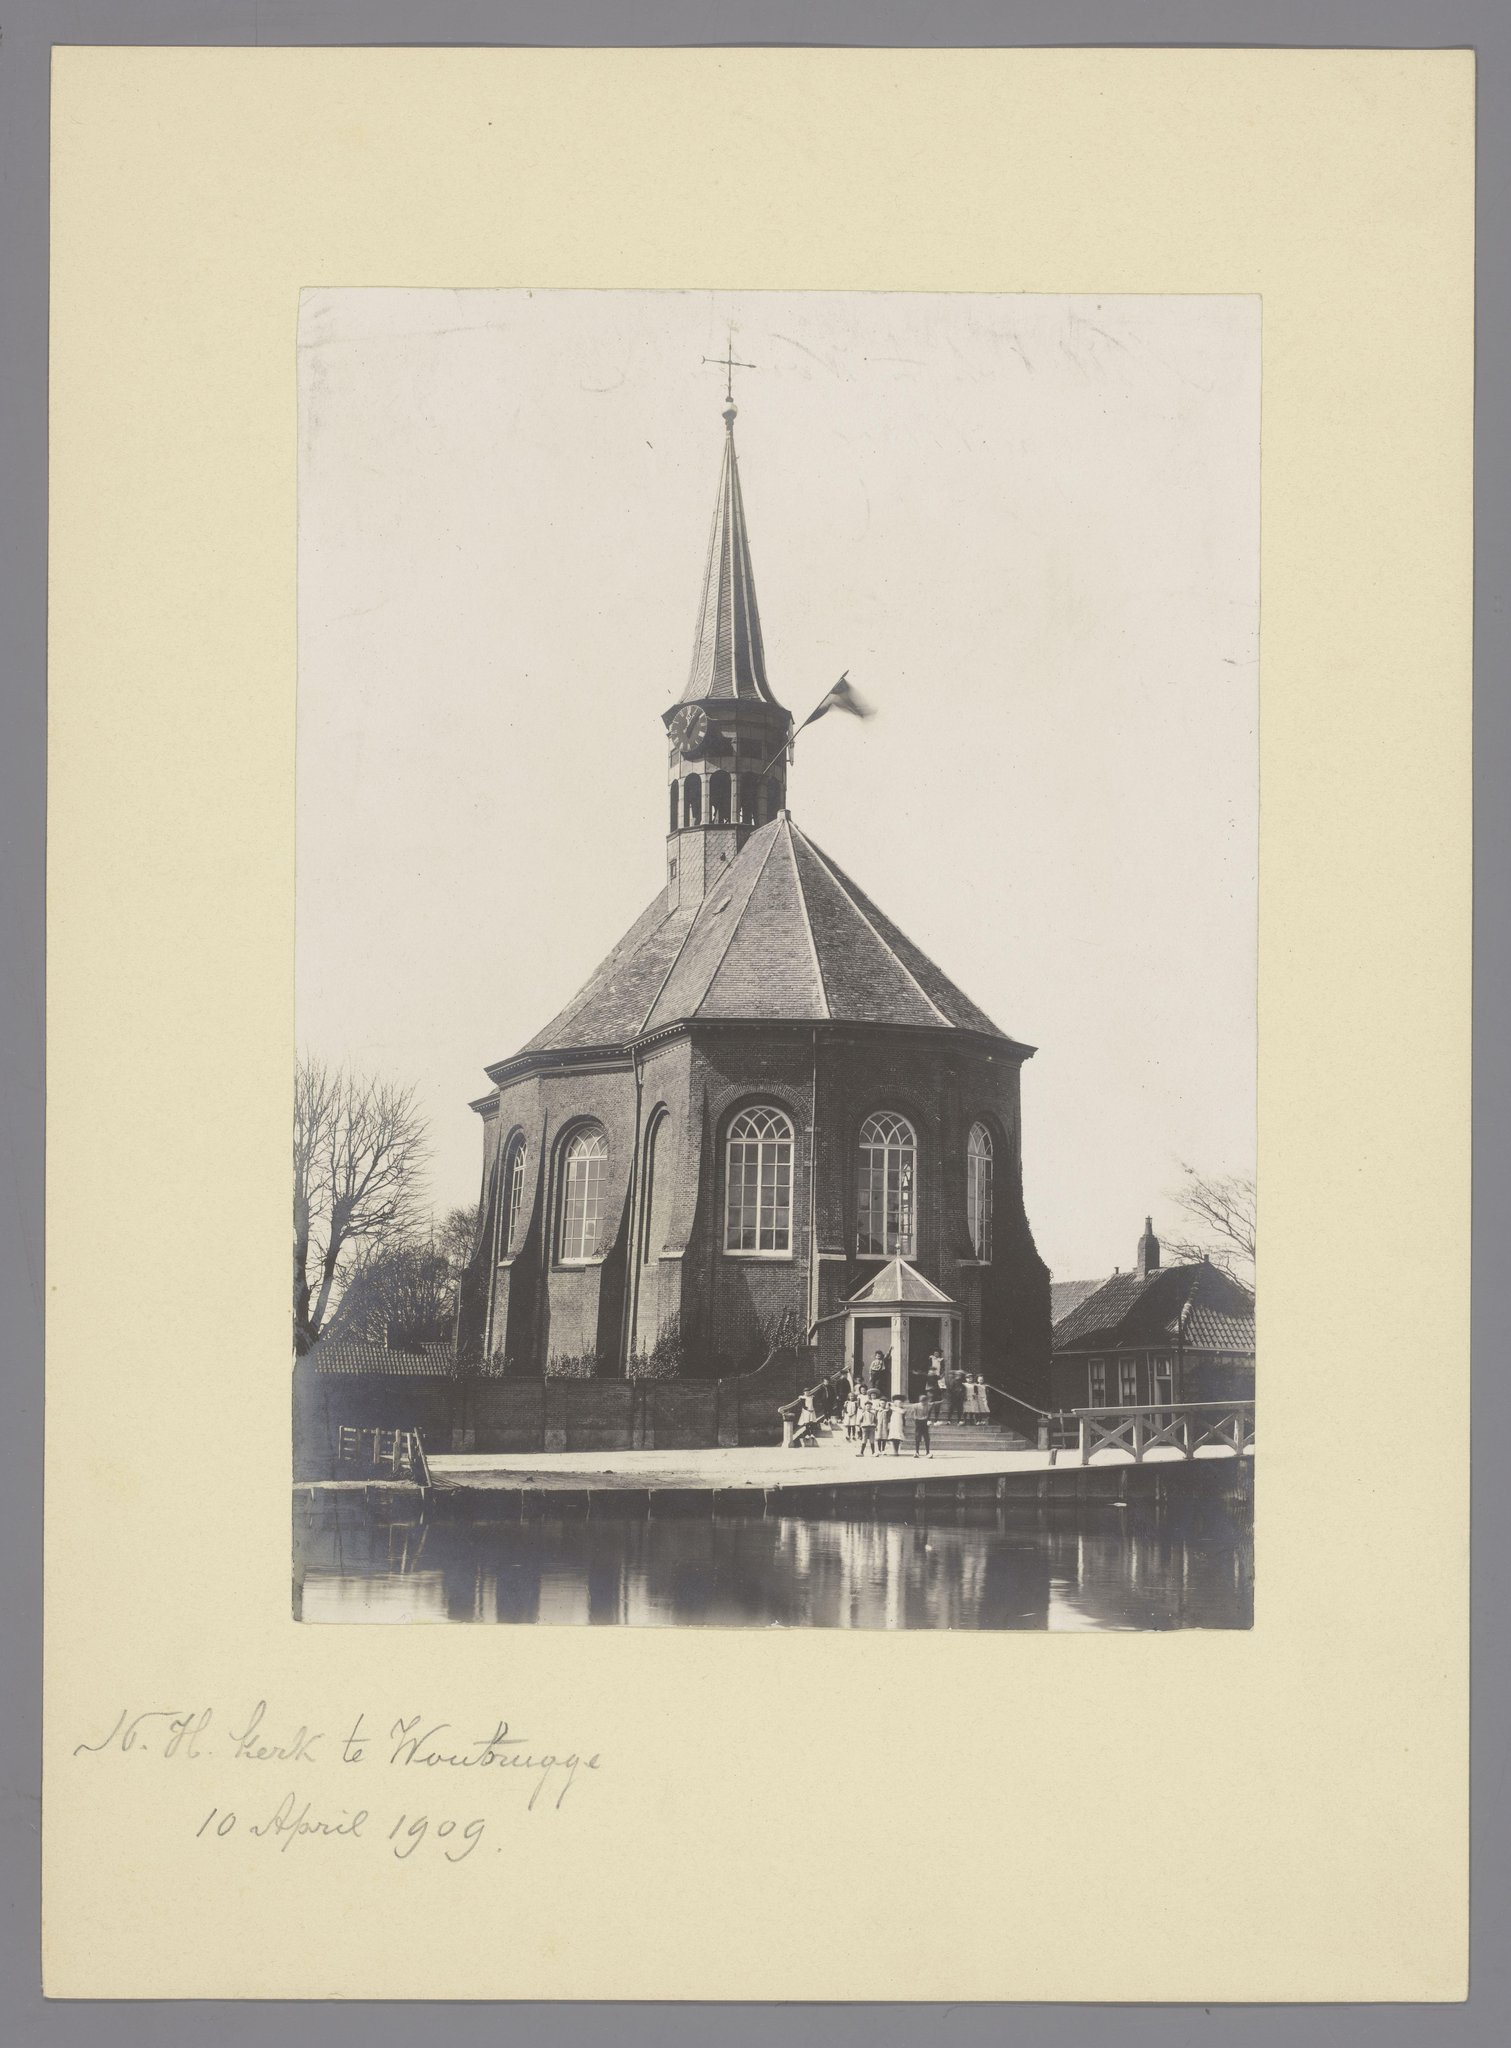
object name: photograph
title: Gezicht op de Dorpskerk te Woubrugge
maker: anoniem (monumentenzorg)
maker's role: fotograaf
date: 1909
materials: cardboard, photographic support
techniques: gelatin silver print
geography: woubrugge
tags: church (exterior)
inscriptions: annotation: ‘N.H. kerk te Woubrugge/ 10 April 1909’, annotation: ‘J. Rendorp/ 1728-1792’